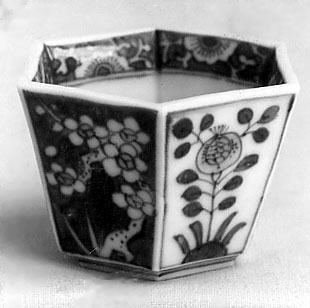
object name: cup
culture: japanese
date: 1801-1900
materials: porcelain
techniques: underglaze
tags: flowers,leaves